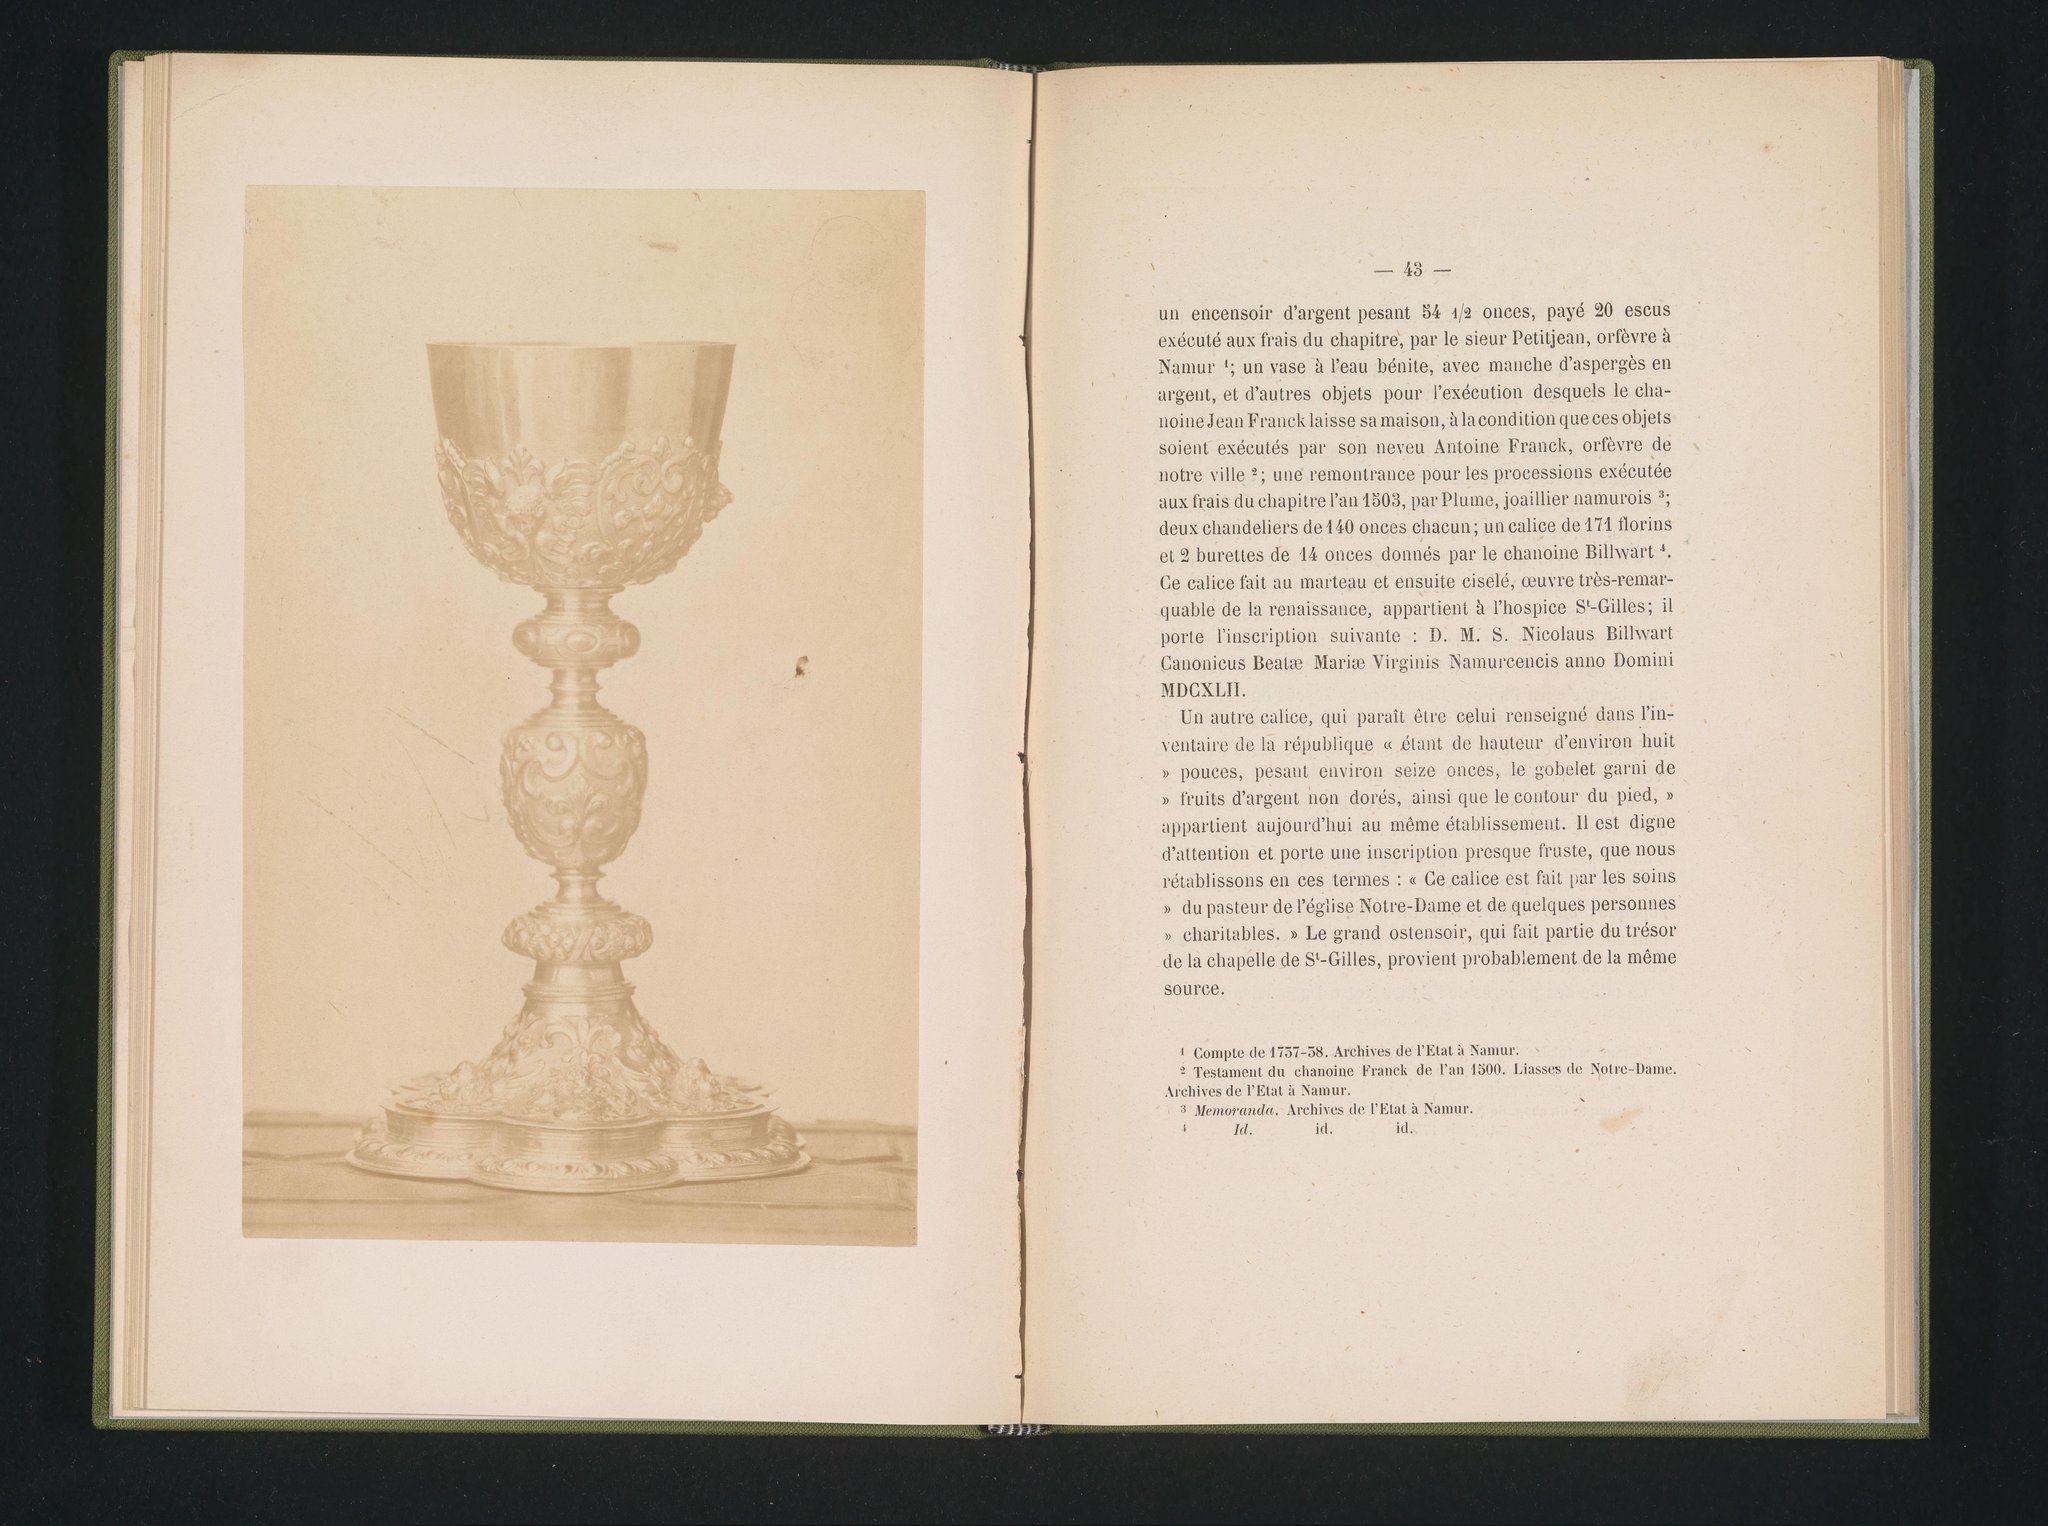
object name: page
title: Kelk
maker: Anonymous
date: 1870-1875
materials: photographic support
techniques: albumen print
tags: chalice